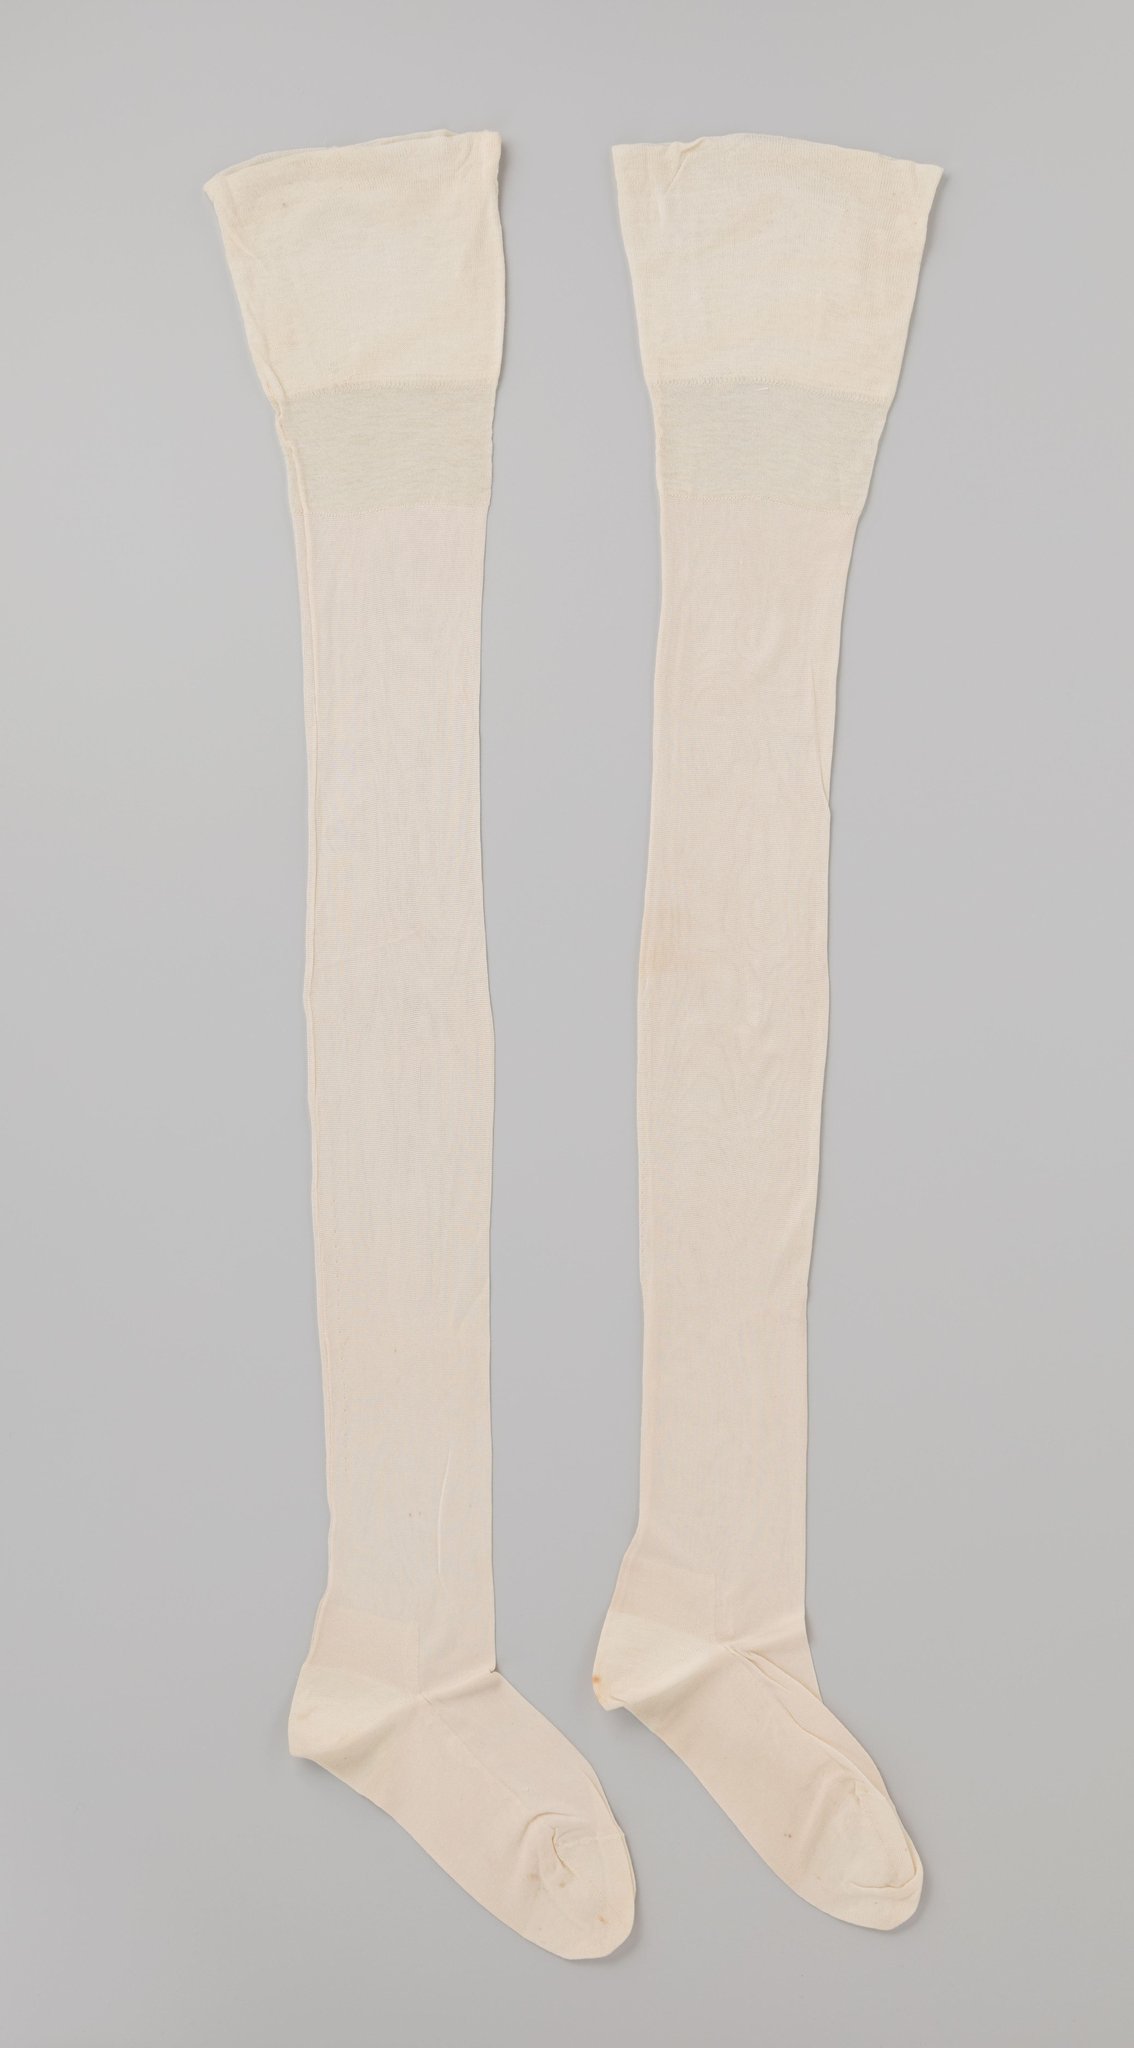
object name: clothing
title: Kous gebreid van witte zijde met brede katoenen boord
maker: Anonymous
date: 1910-1920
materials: cotton, silk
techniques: knitting, printing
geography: lille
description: Kous van witte zijde. Model: met naad. Boord van katoen. Vierkante hiel.